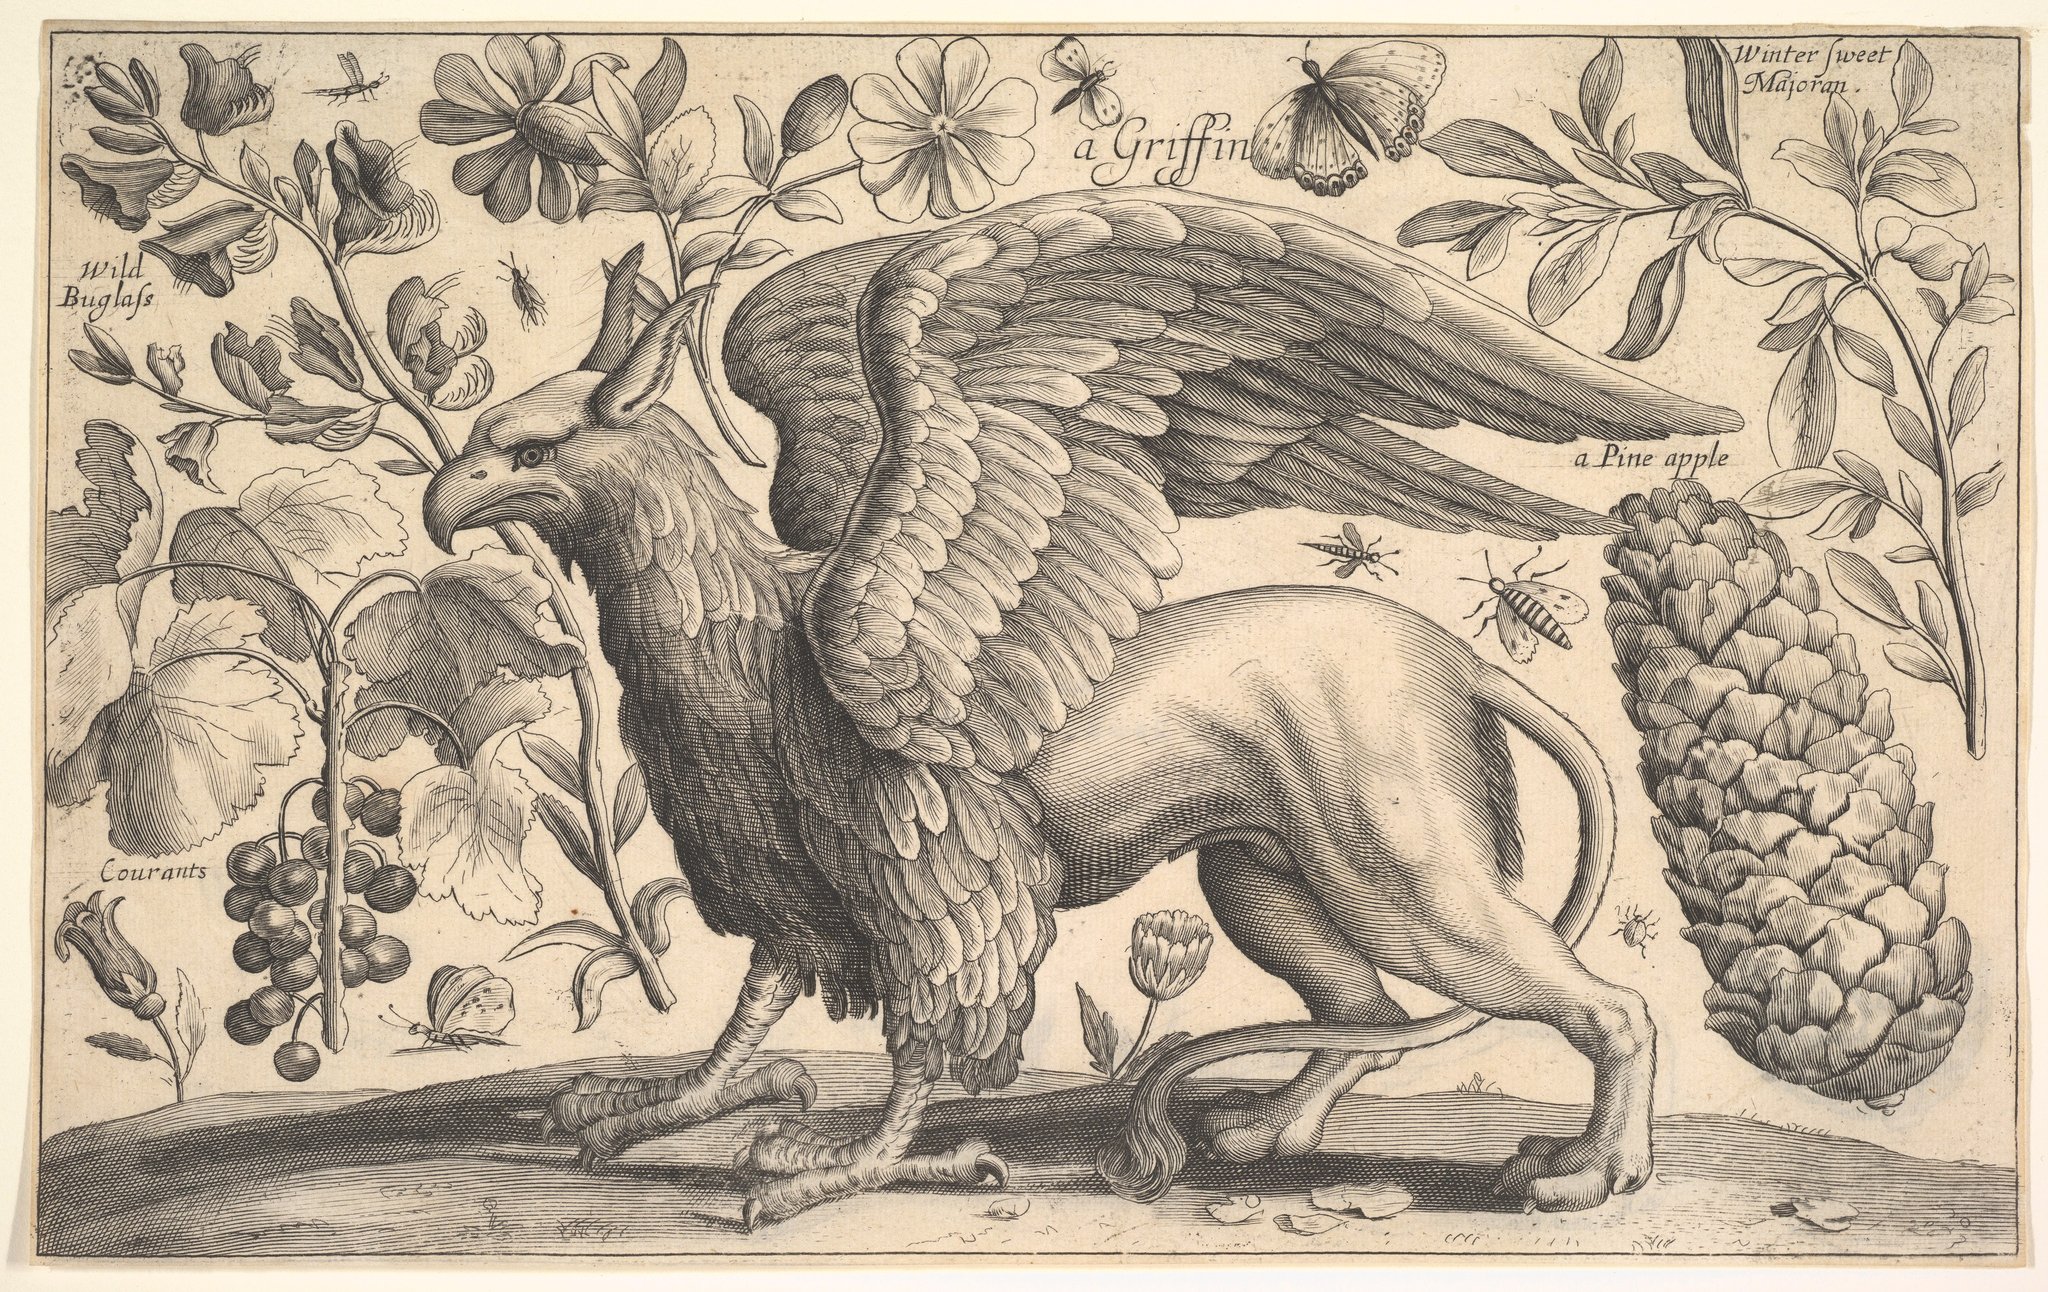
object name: print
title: A Griffin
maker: wenceslaus hollar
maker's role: artist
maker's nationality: bohemian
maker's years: 1607-1677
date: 1662-1663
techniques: etching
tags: grapes,griffins,butterflies,flowers,leaves